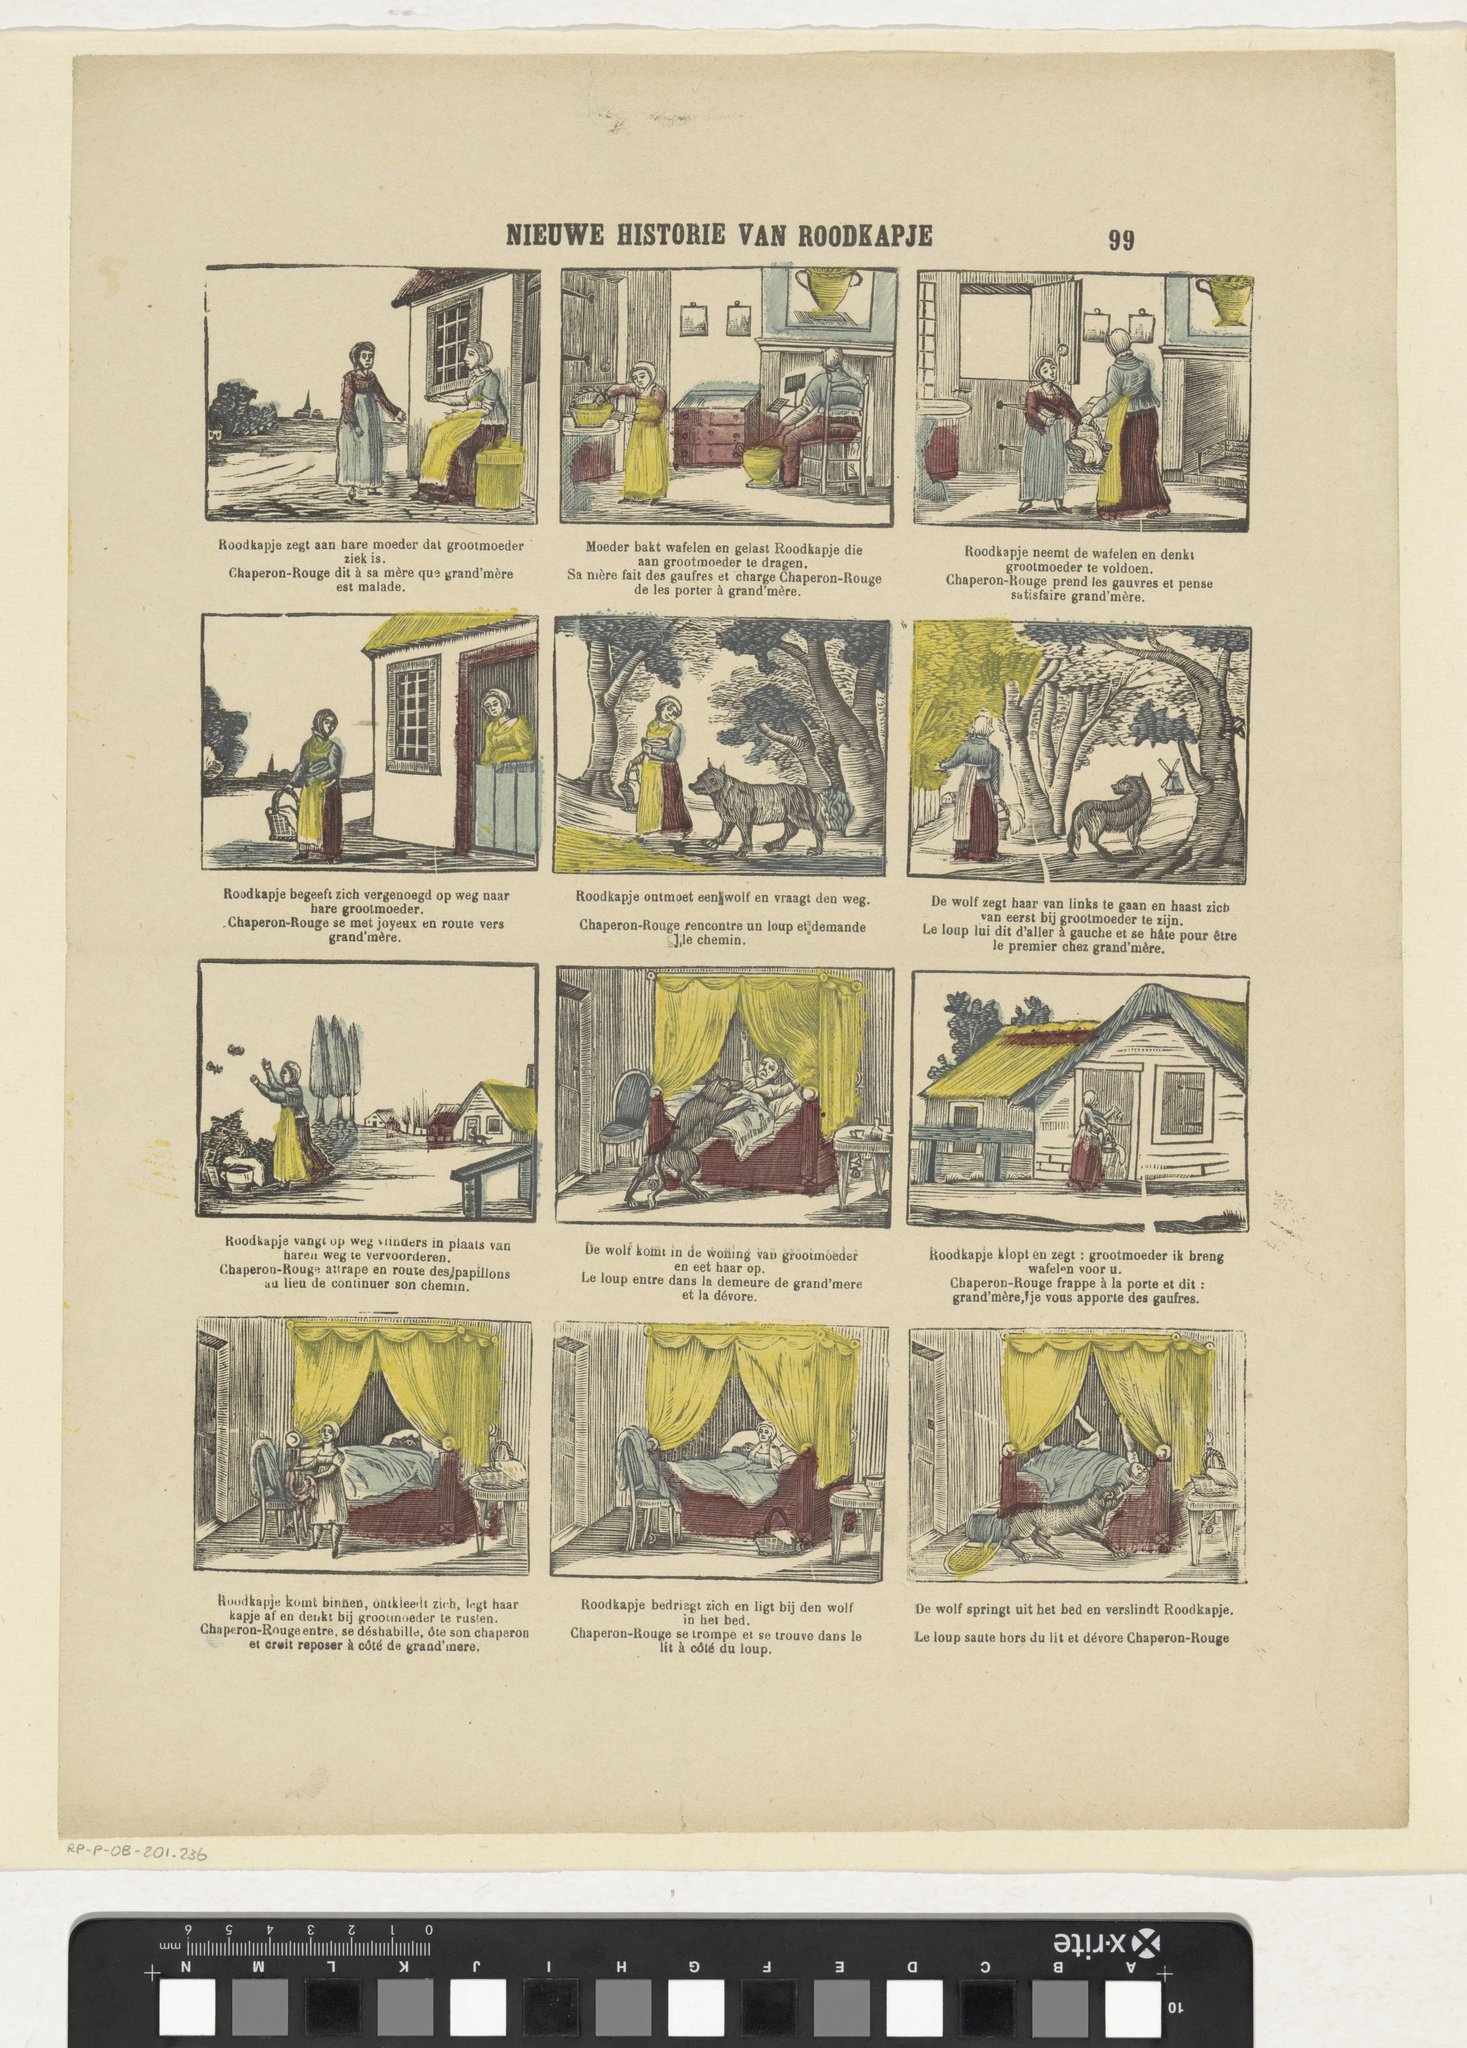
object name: print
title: Nieuwe historie van Roodkapje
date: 1866-1902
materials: paper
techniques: colour, letterpress printing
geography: europe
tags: tales and fairy tales: little red riding-hood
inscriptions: collector's mark: Lugt 2760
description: Blad met 12 voorstellingen uit het sprookje van Roodkapje. Onder elke afbeelding een tweeregelig vers in het Nederlands en in het Frans. Genummerd rechtsboven: 99.